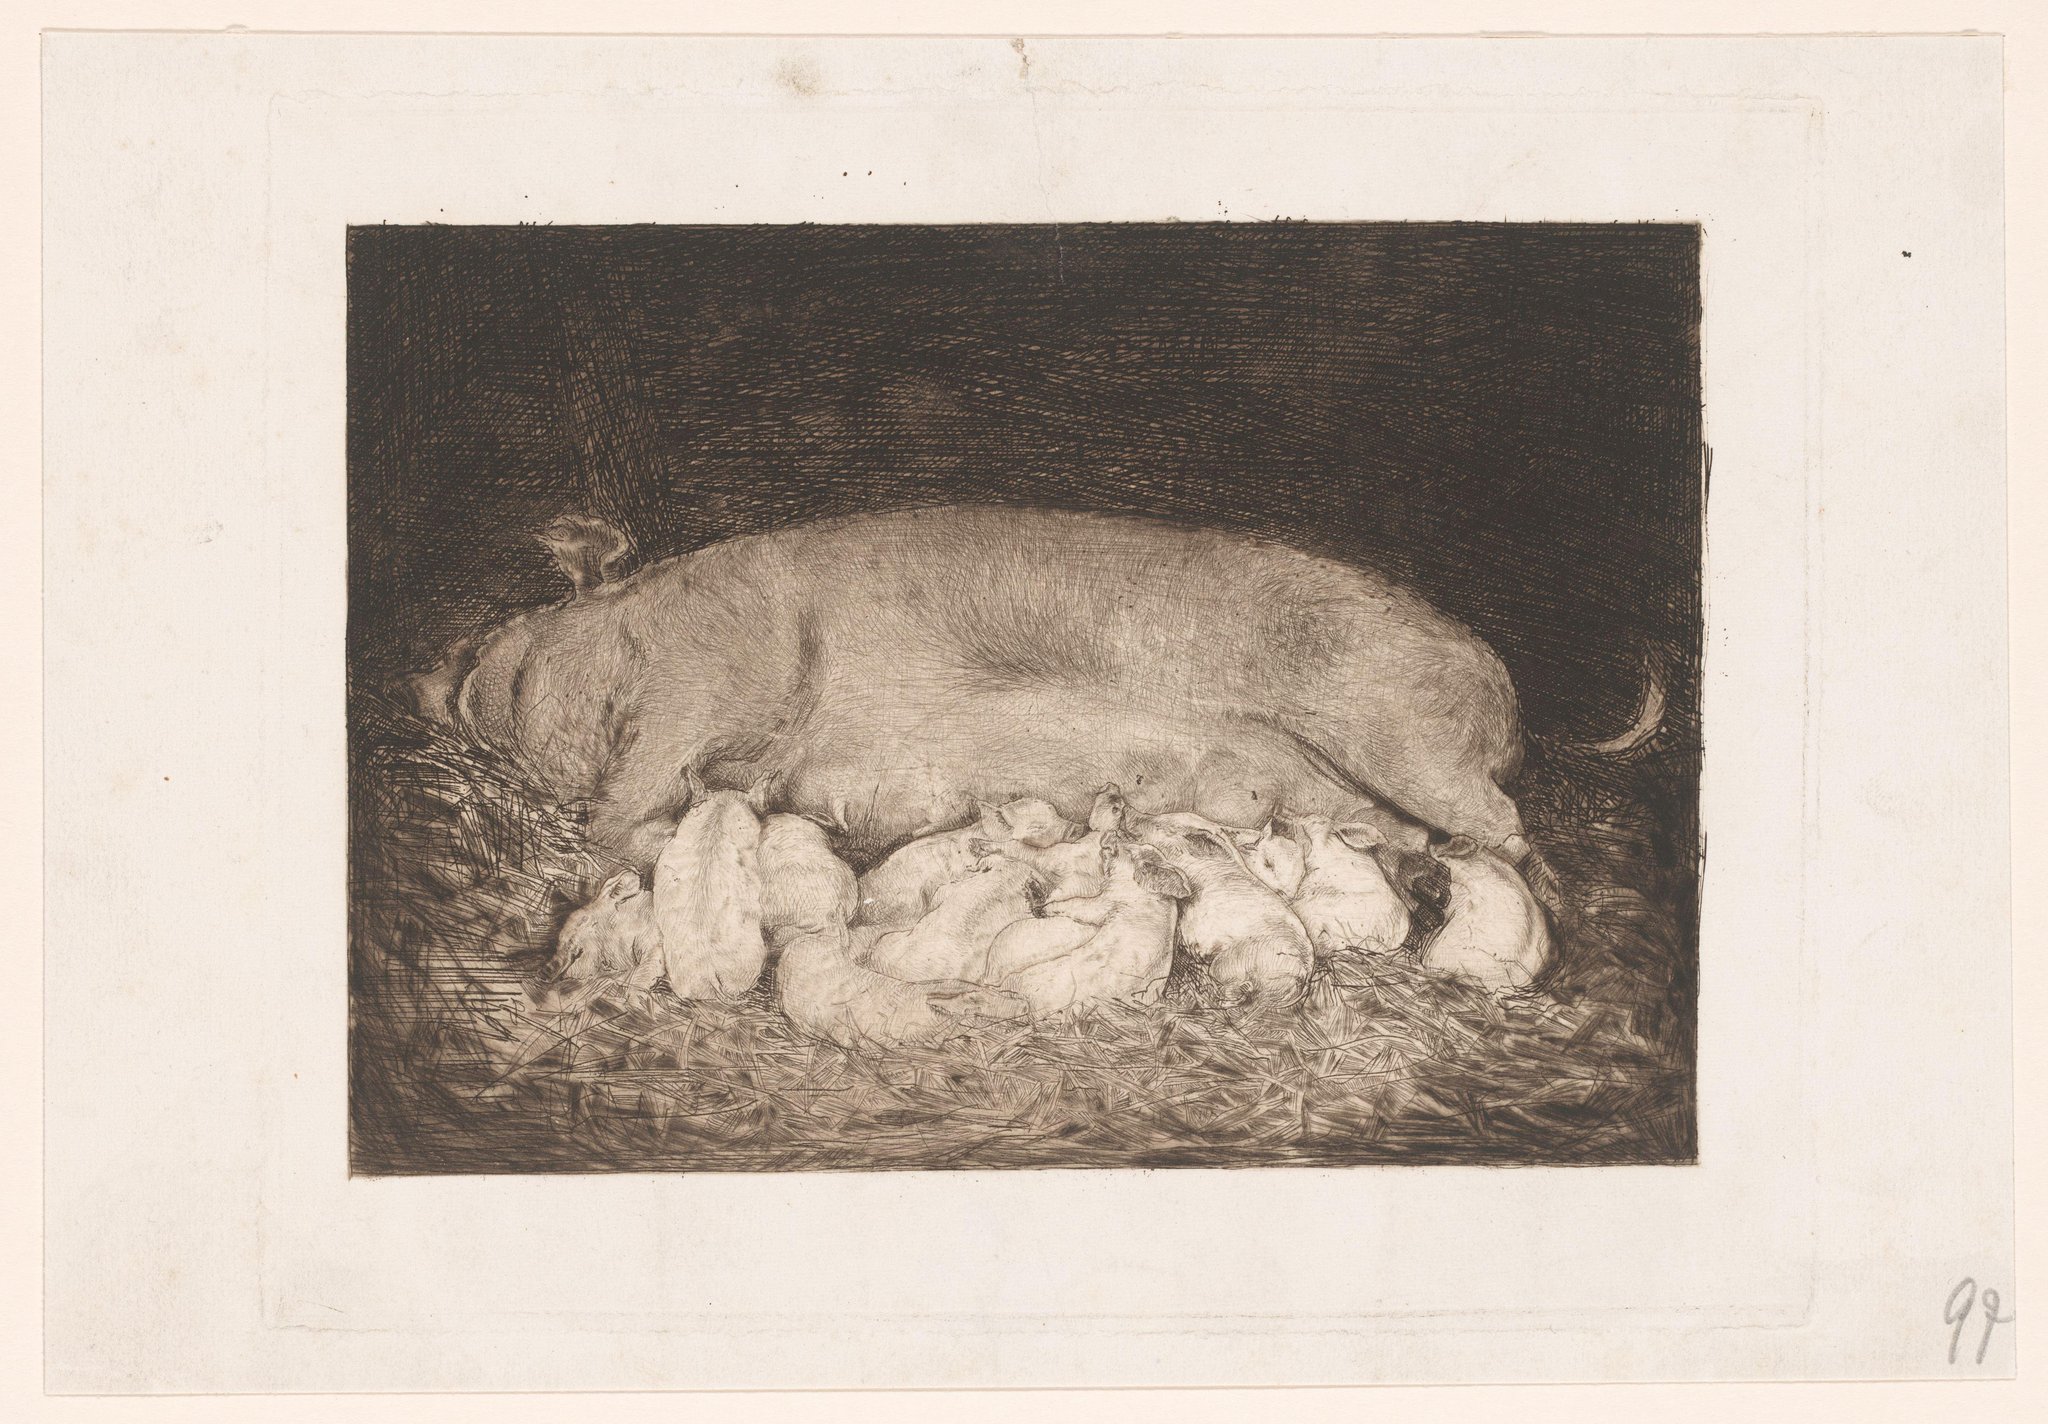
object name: print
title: Zeug met biggen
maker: nicolaas van der waay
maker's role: draughtsman, painter, print maker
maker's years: 1855-1936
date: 1865-1936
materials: paper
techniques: drypoint, etching, intaglio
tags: pig, piglet, suckling pig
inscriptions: collector's mark: Lugt 2228